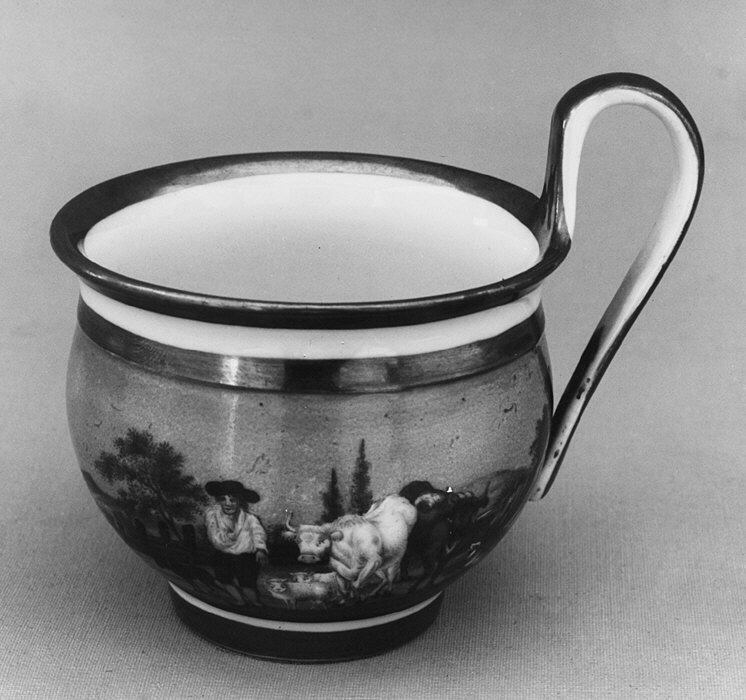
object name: cup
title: Cup (one of six) (part of a set)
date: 1820-1830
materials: hard paste porcelain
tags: men,cows,trees